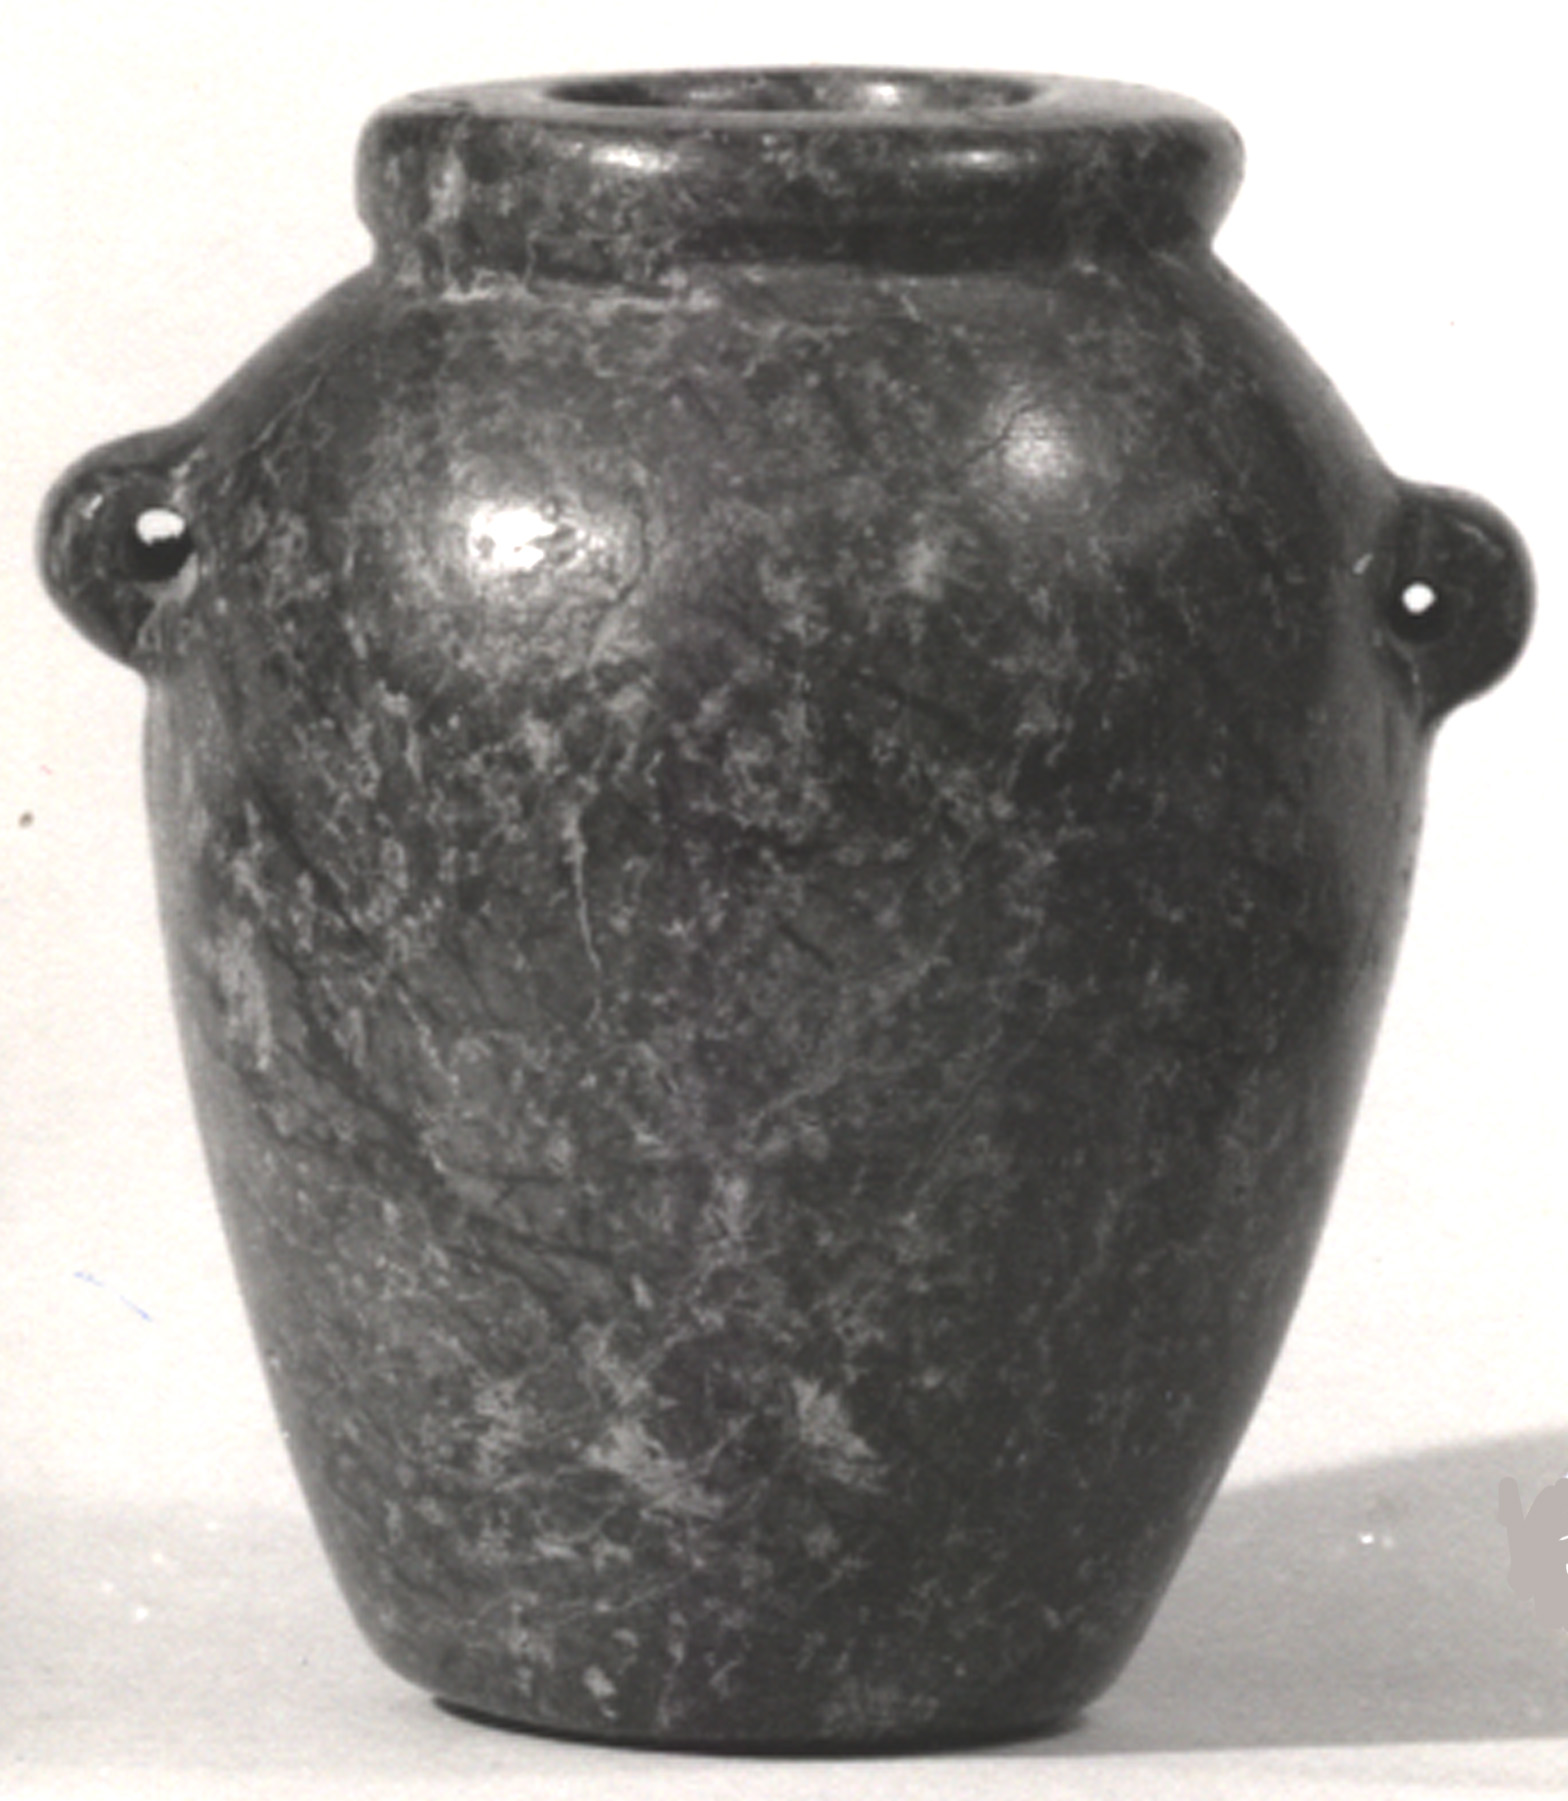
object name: jar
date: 3850-2960 BCE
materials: stone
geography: egypt